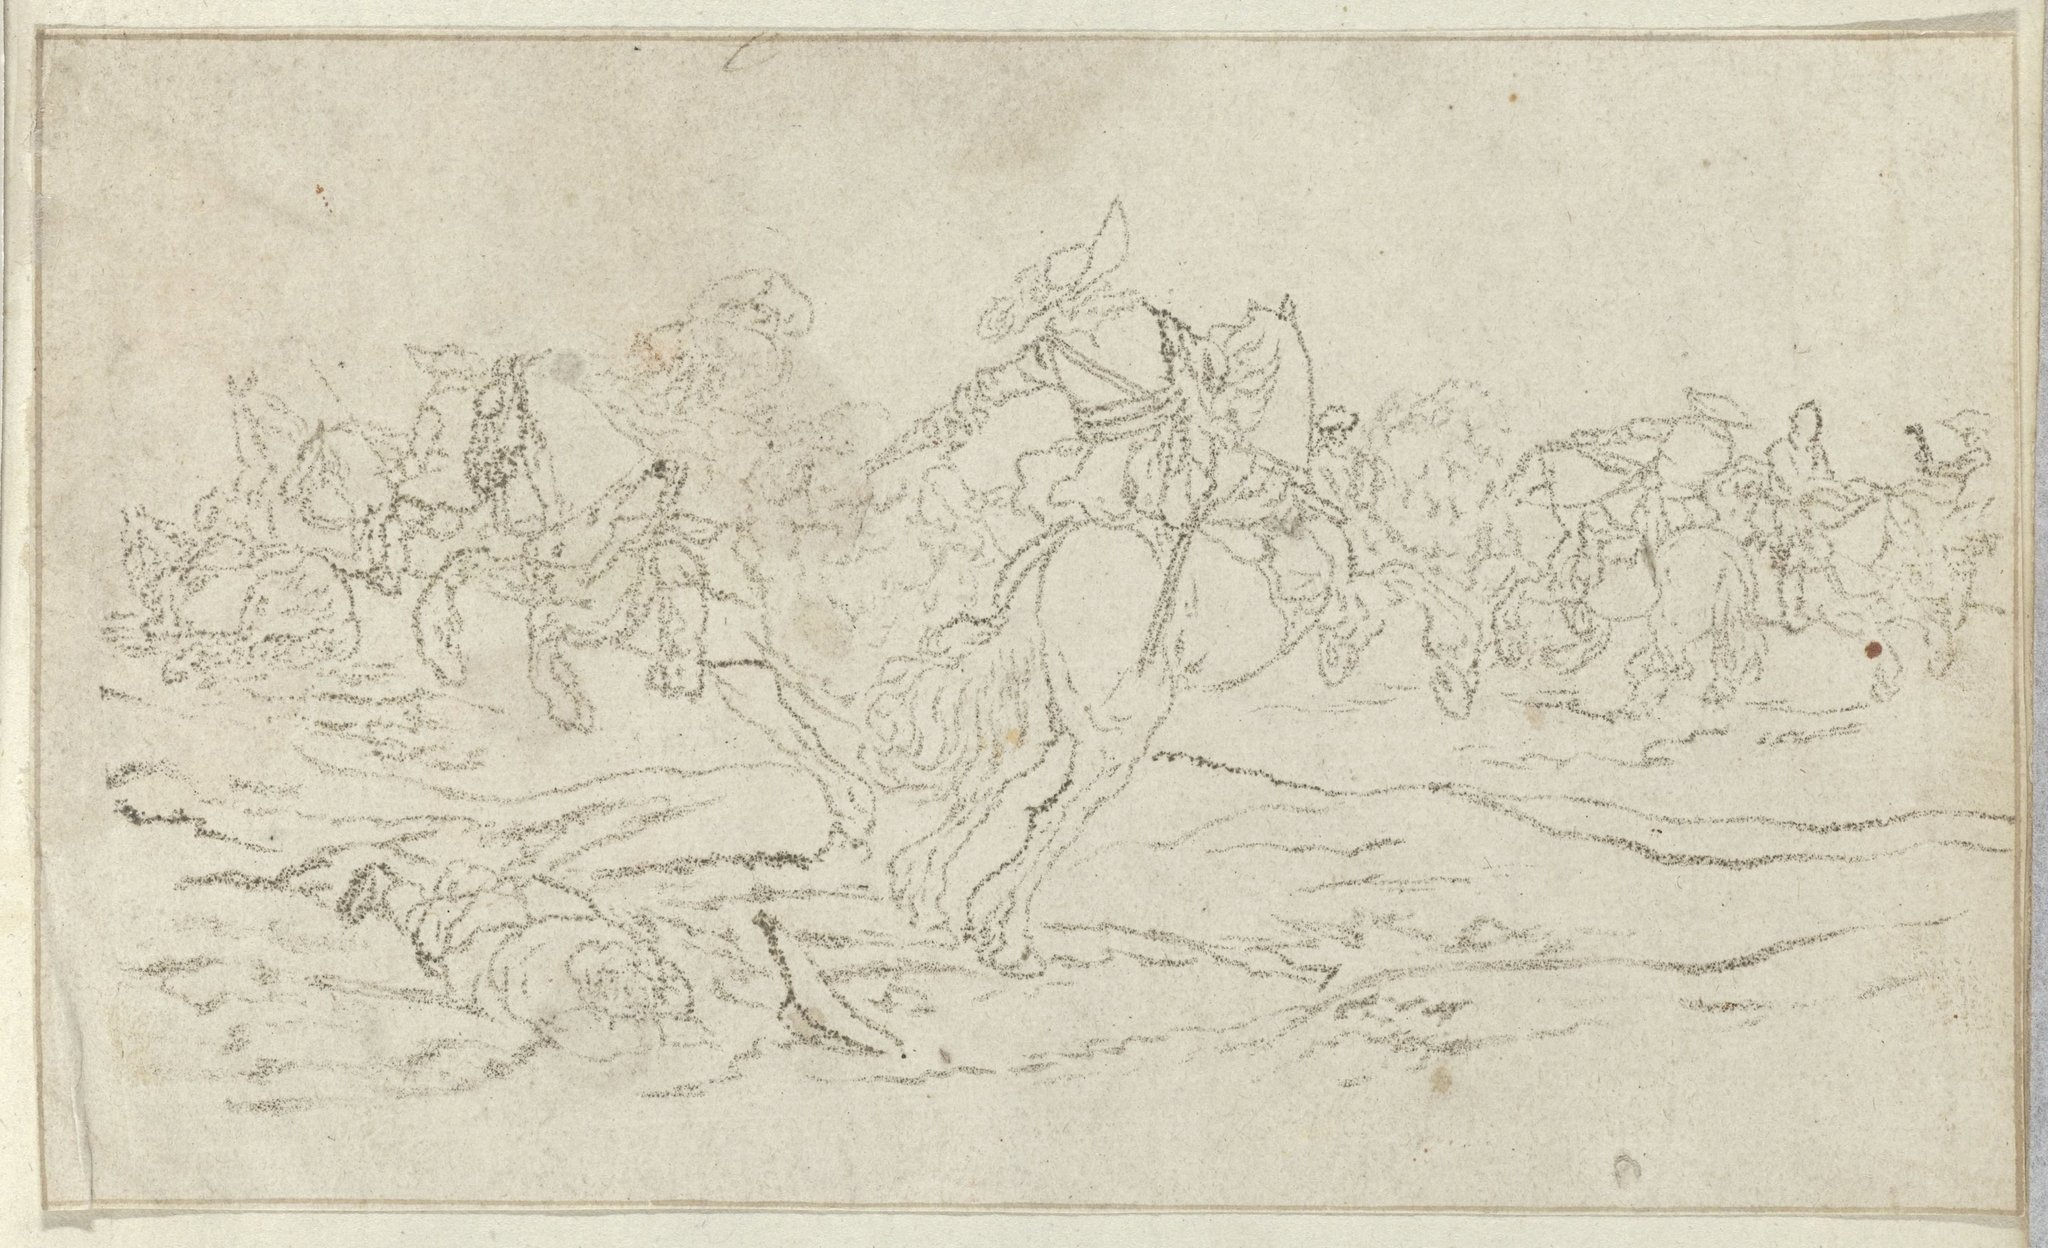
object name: drawing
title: Ruitergevecht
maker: Anonymous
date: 1700-1799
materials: paper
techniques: printmaking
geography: netherlands